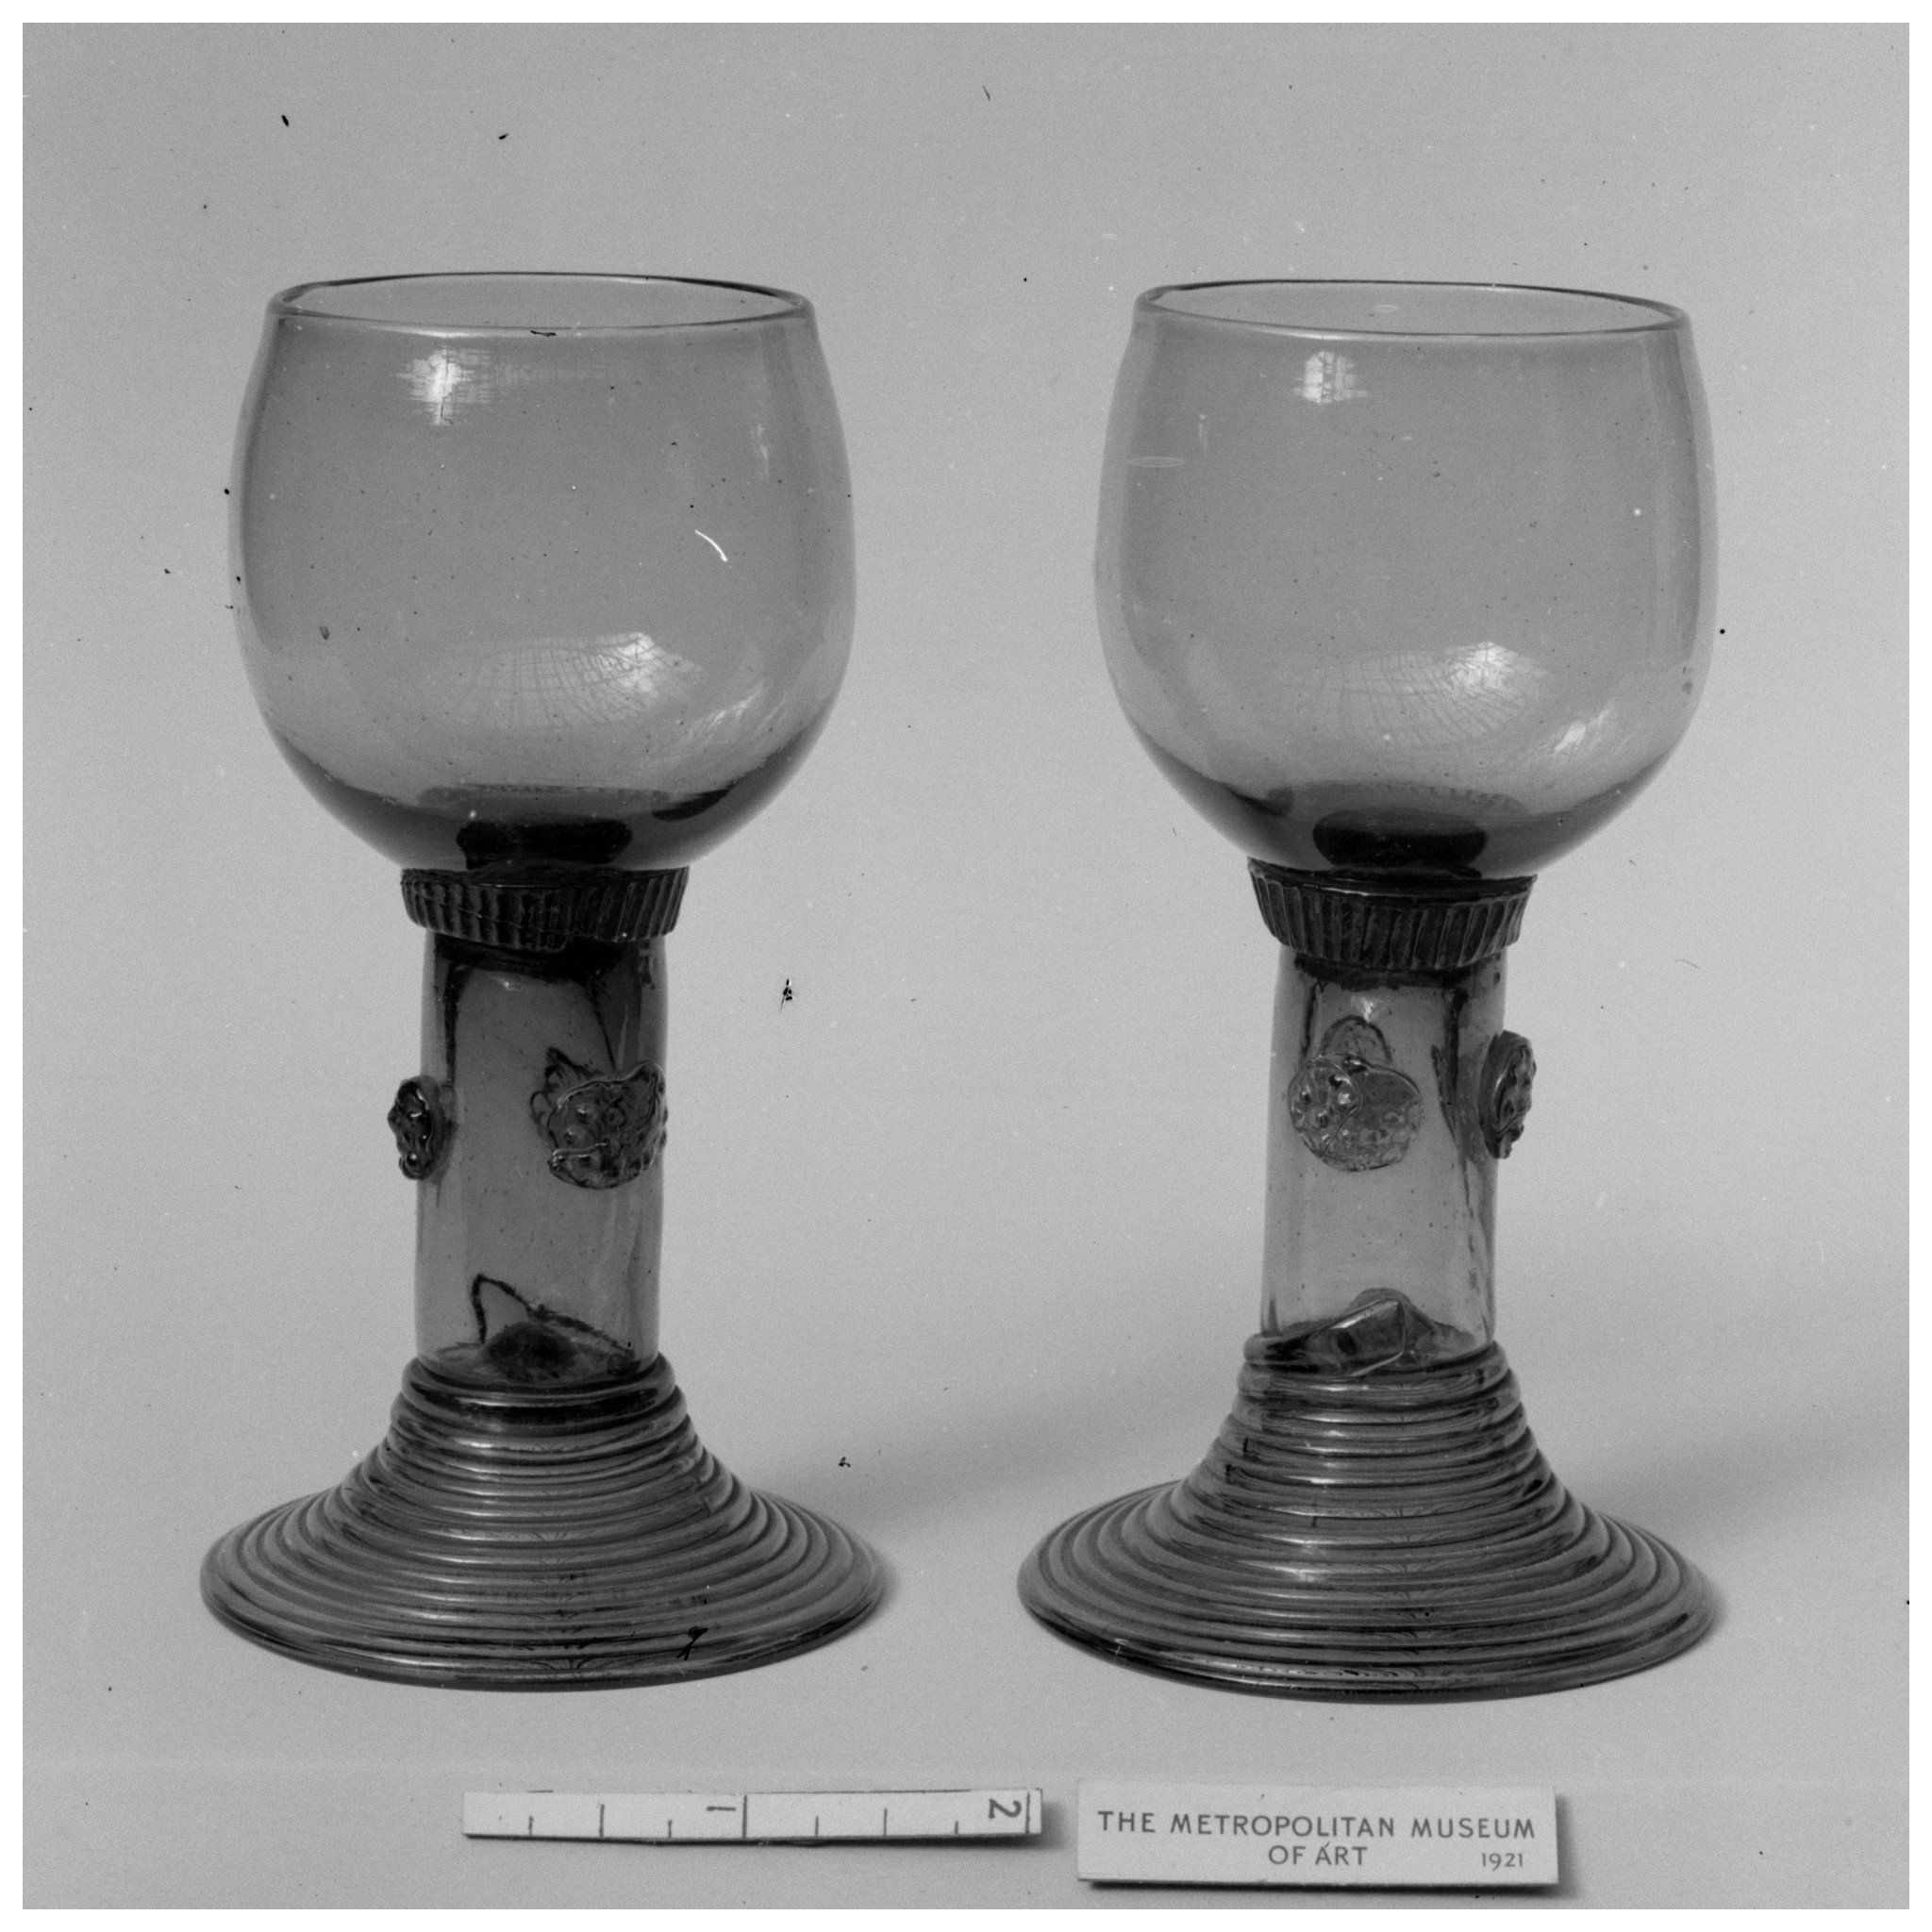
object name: goblet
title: Goblet (Roemer)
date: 1701-1900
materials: glass